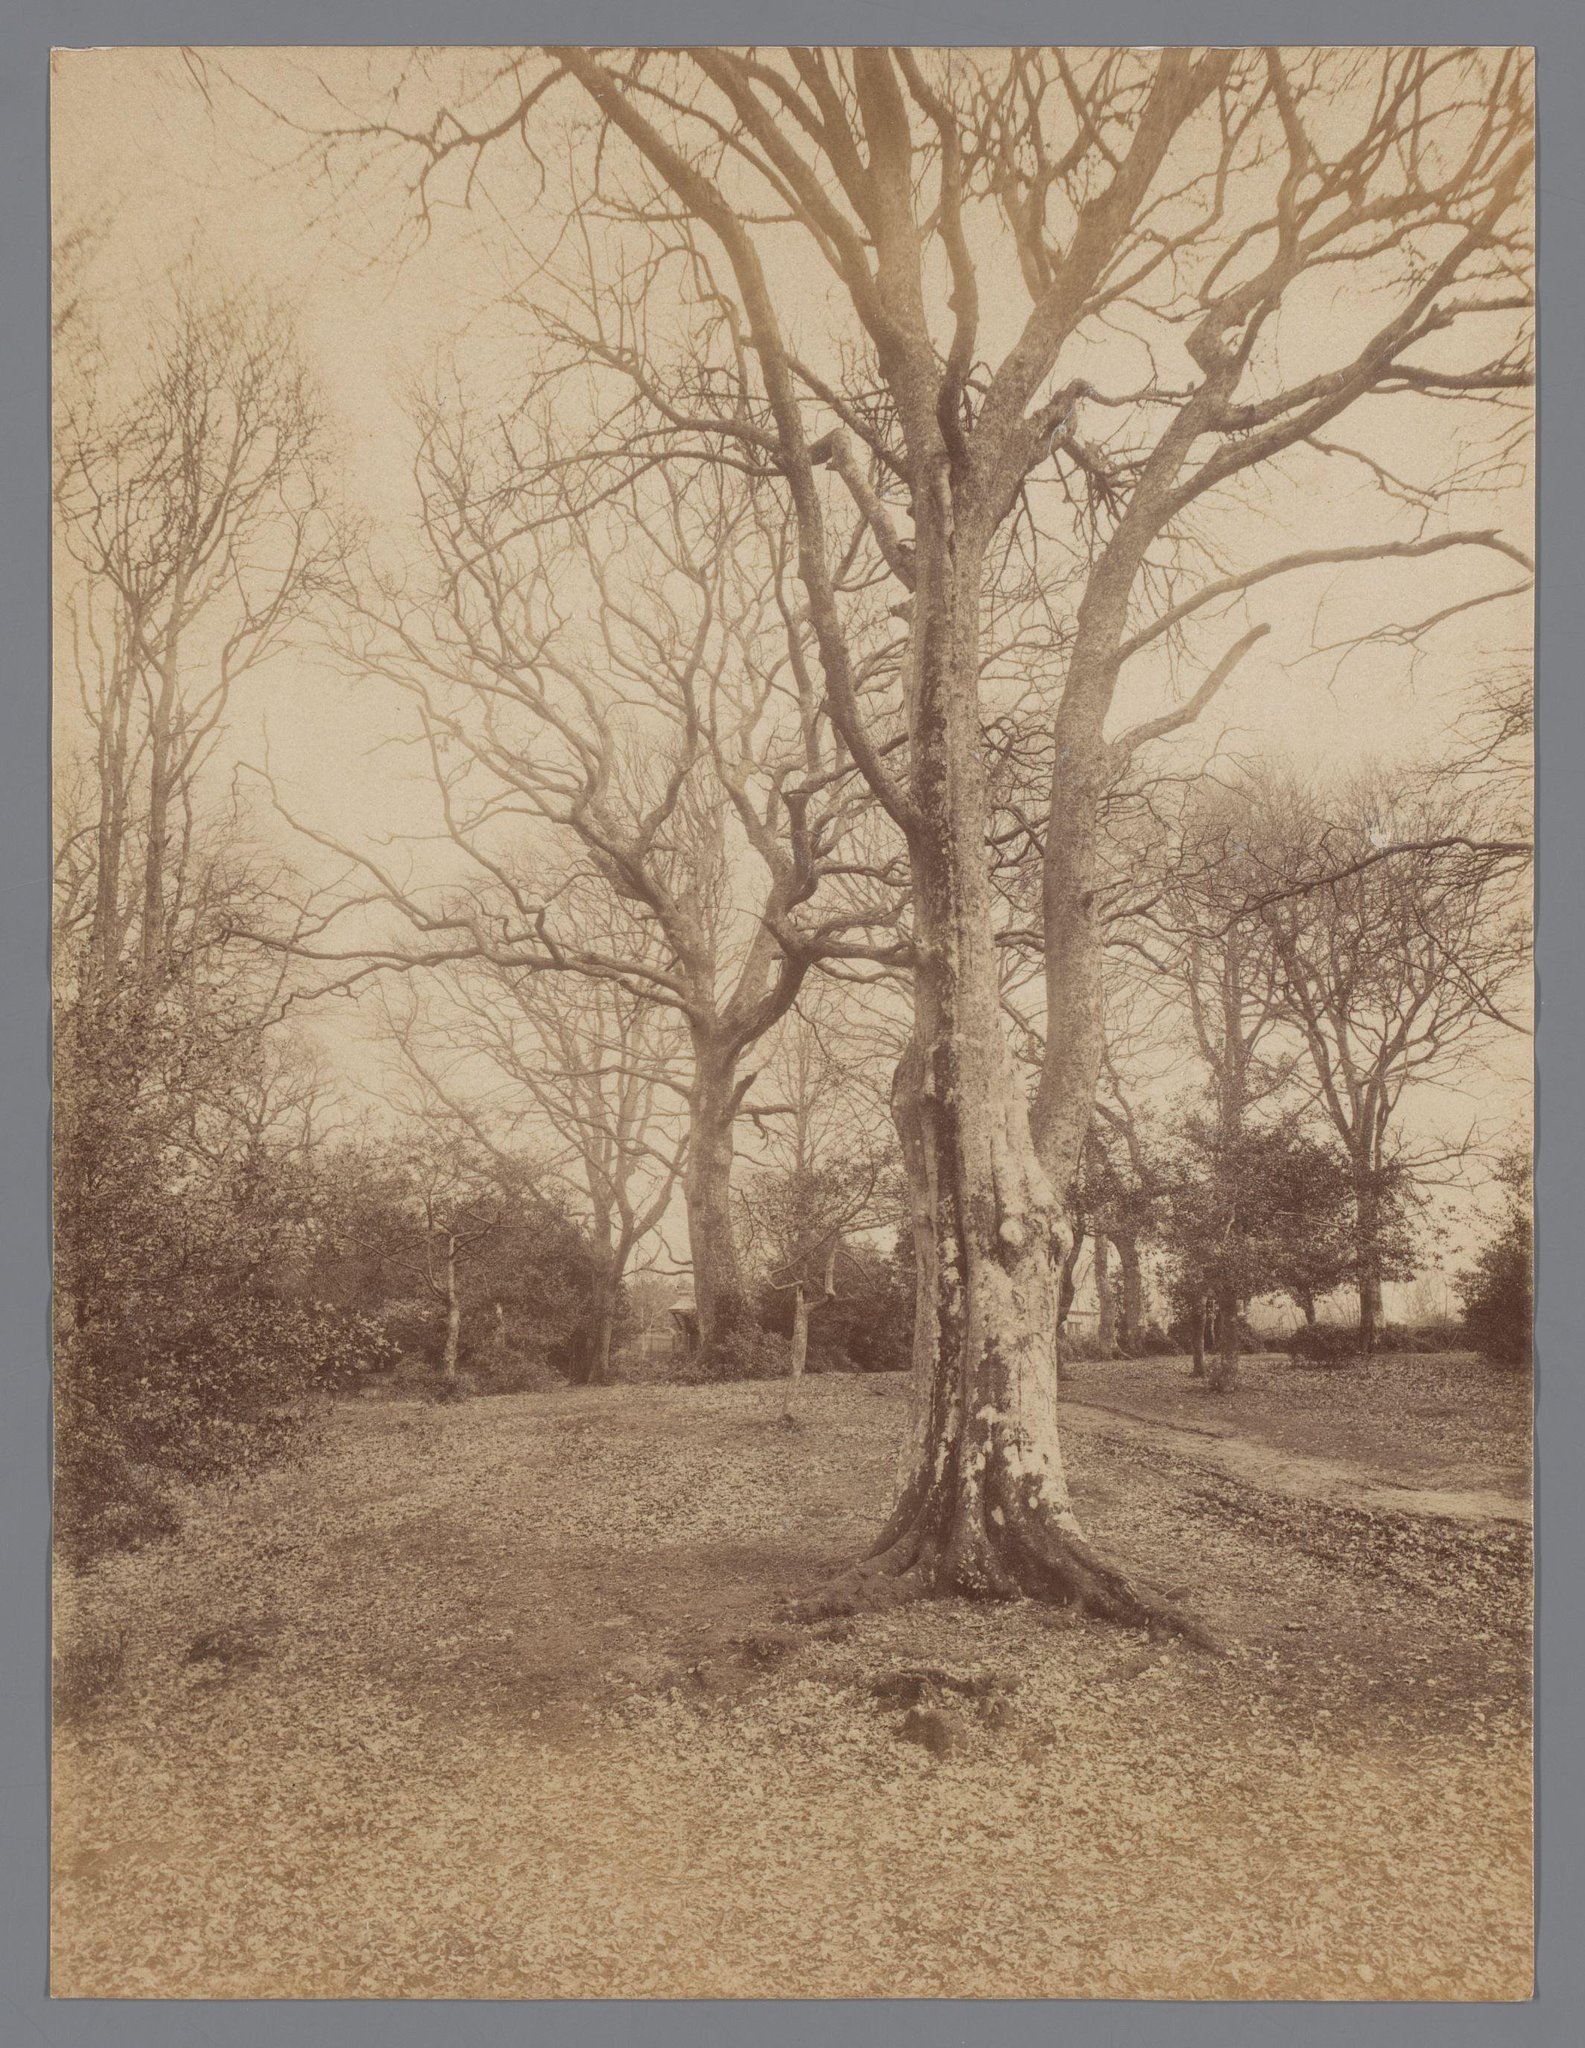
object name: photograph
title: Landschap met kale bomen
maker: Anonymous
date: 1875-1900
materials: paper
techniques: albumen print